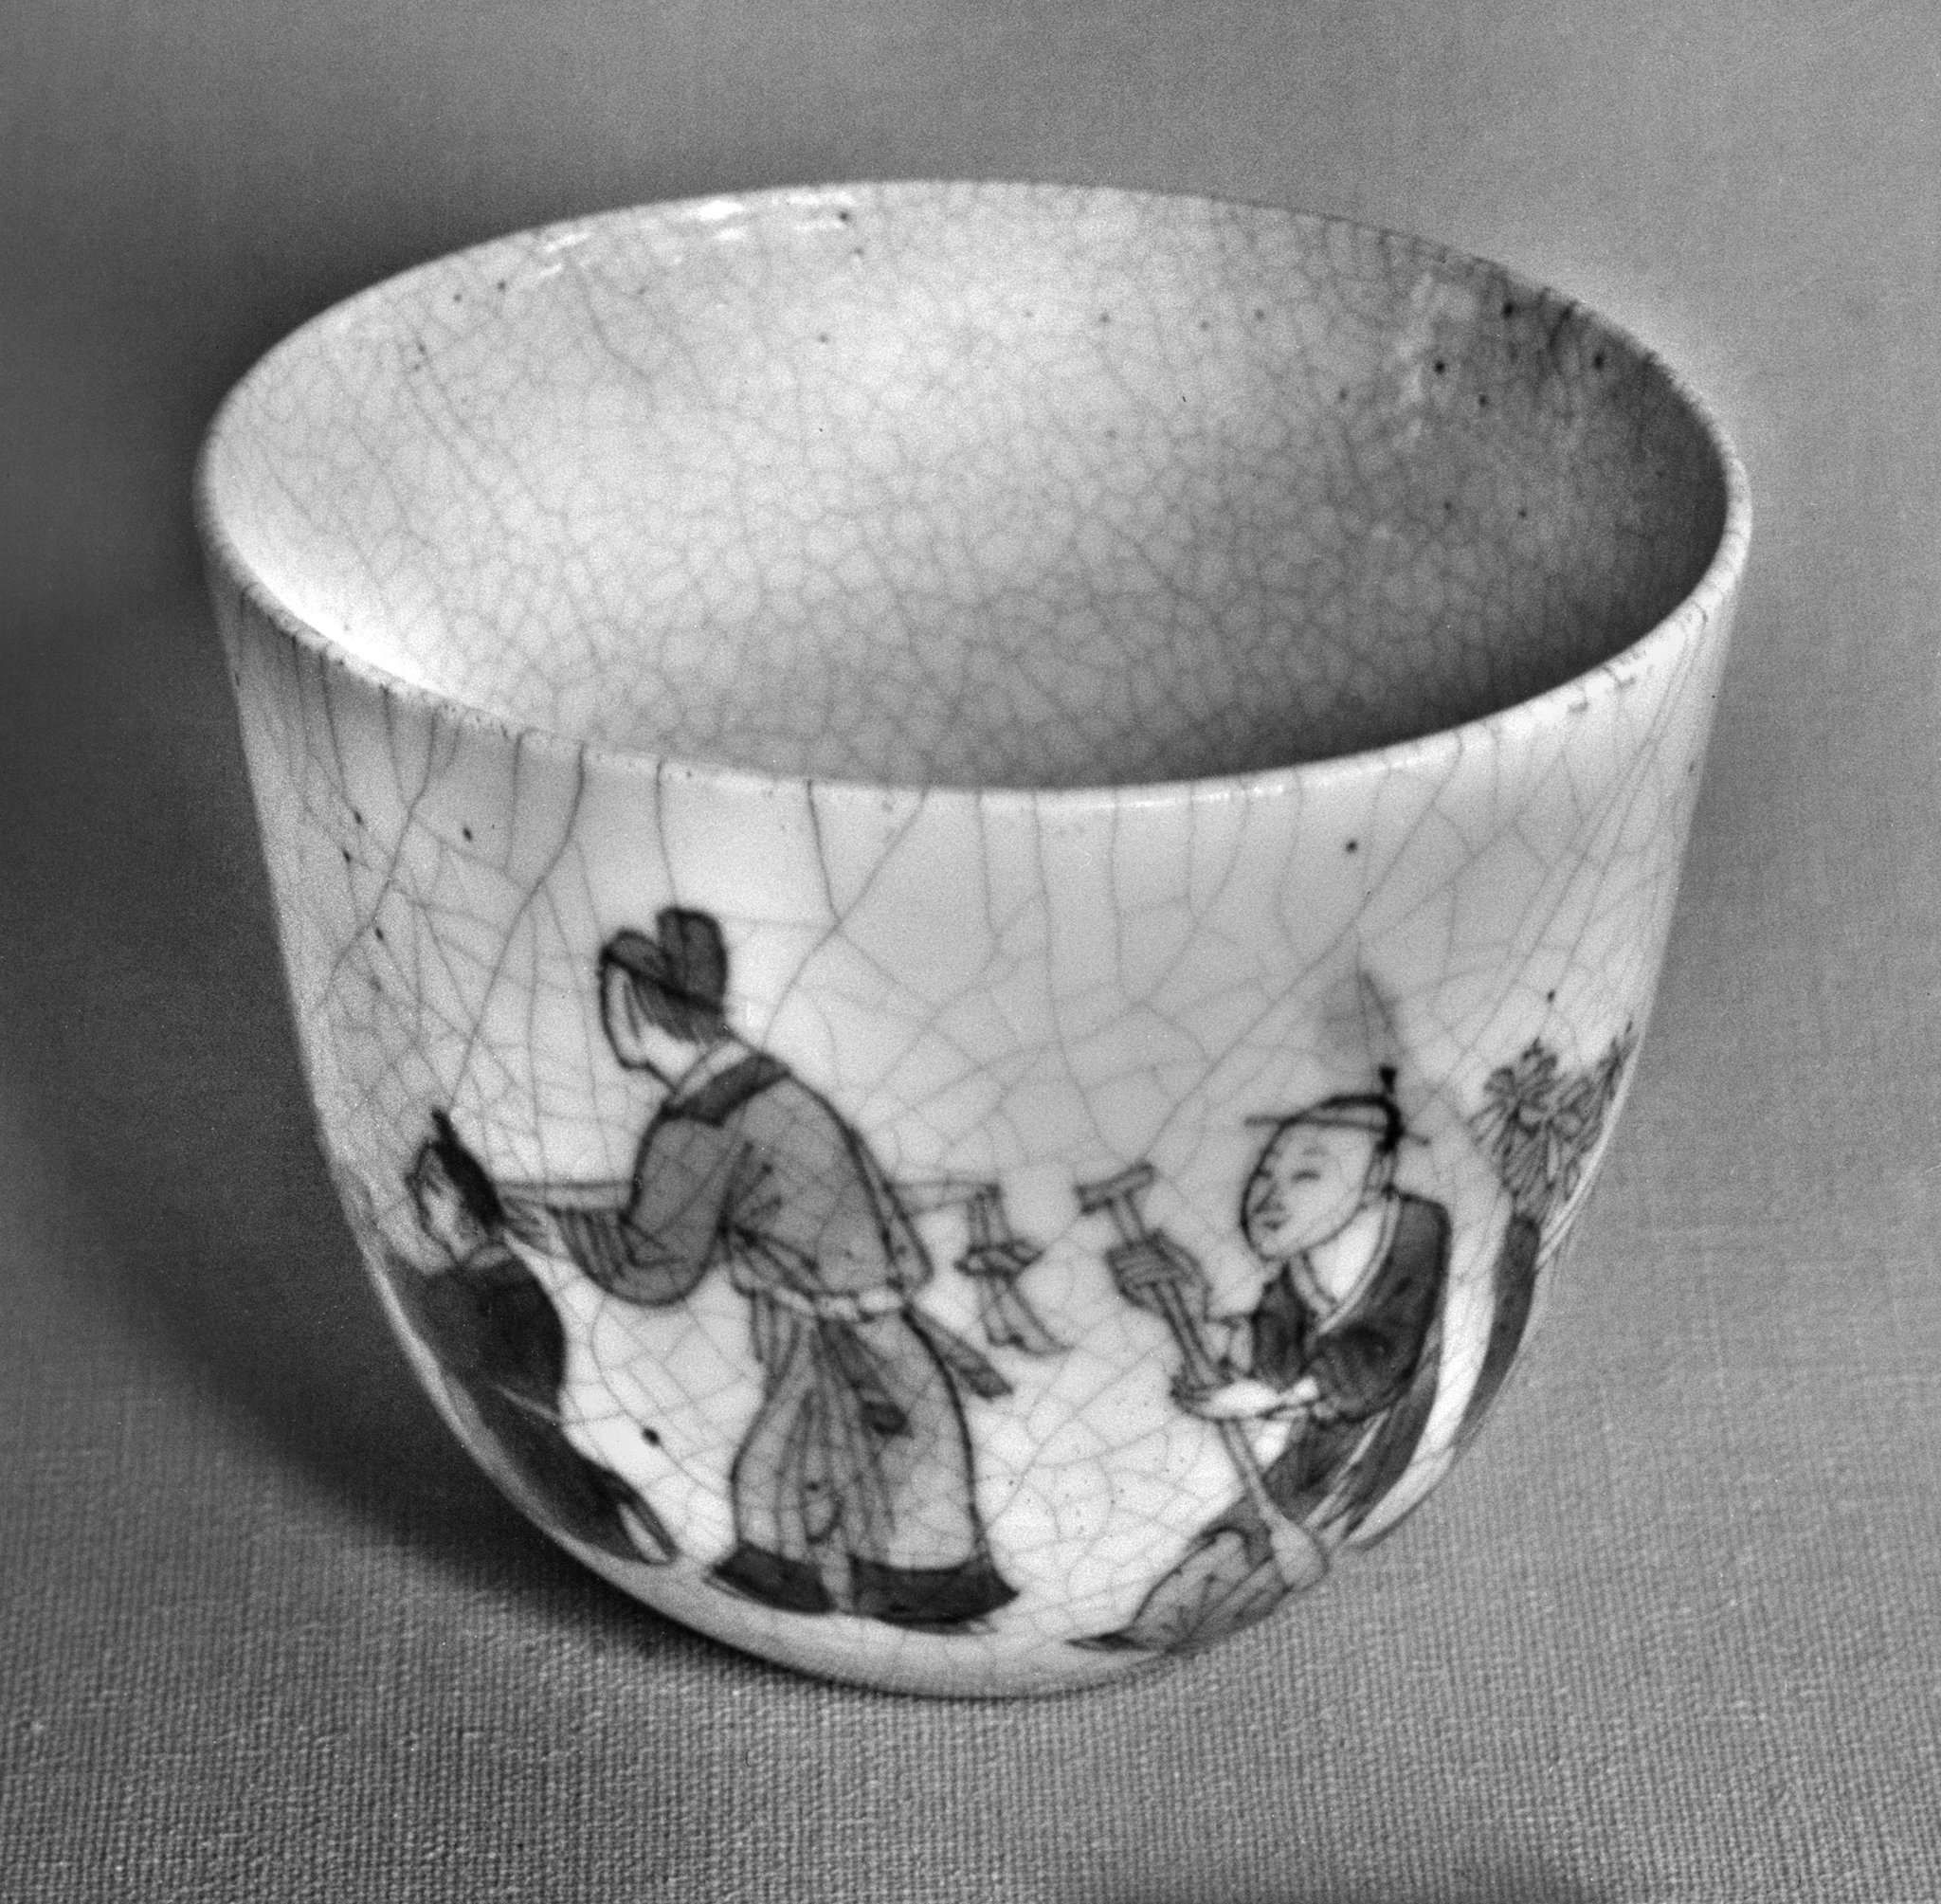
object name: cup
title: Cup with story of Li Bai and poem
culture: chinese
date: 1667-1733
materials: cobalt, soft paste porcelain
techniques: painting, underglaze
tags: men